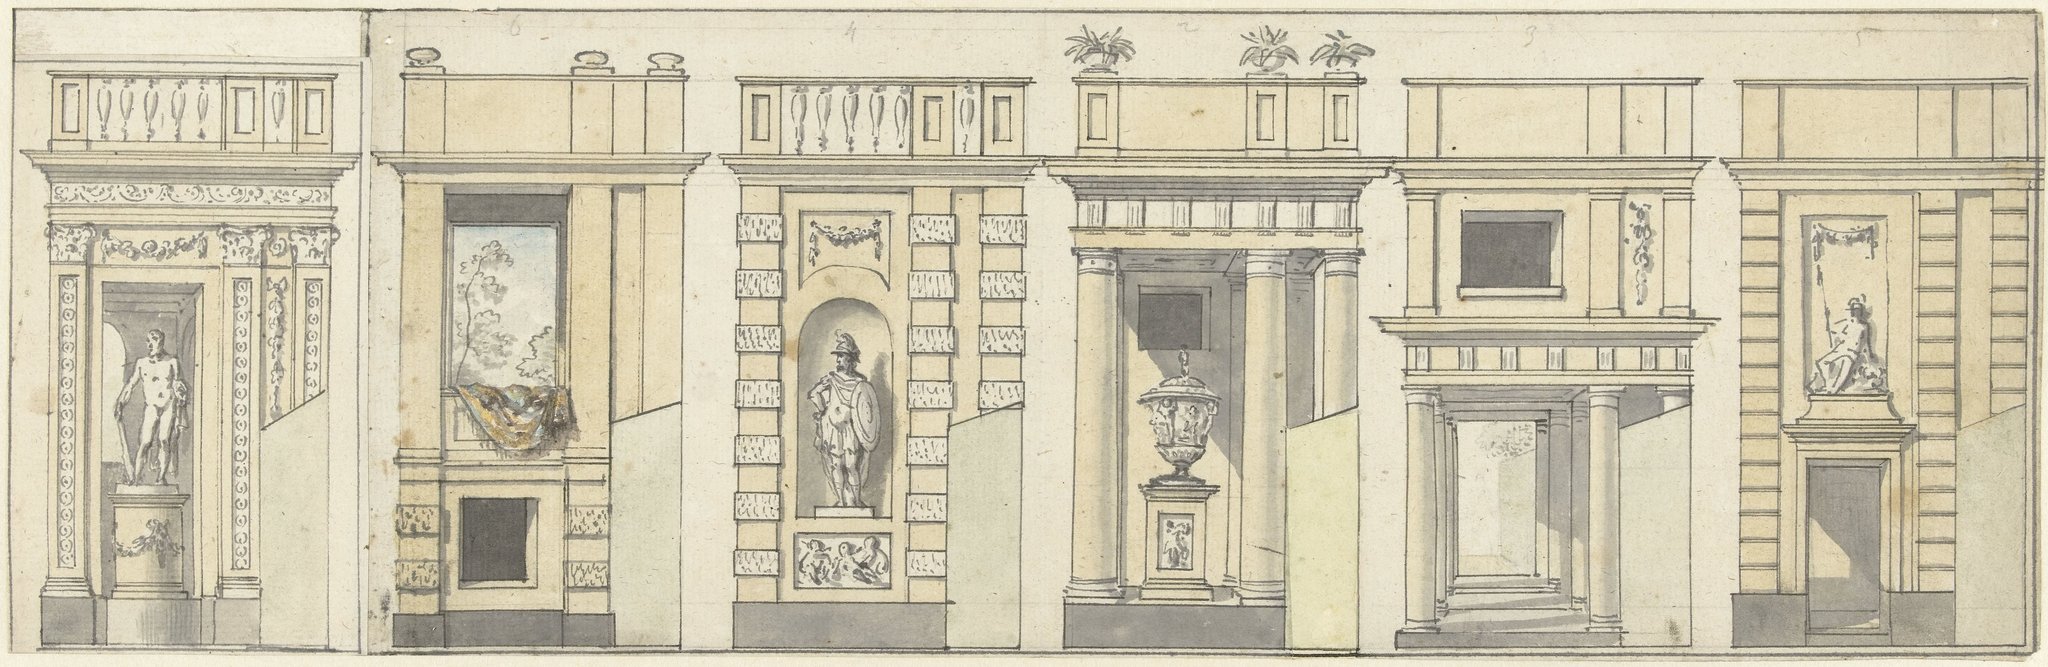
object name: design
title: Zes ontwerpen voor een decoratiewand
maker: jurriaan andriessen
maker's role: draughtsman, painter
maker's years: 1742-1819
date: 1752-1819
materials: graphite, ink, paper, watercolor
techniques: brush, pen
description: Zes ontwerpen voor een decoratiewand (in tuin/buiten). Ontwerp voor een kamerwand.